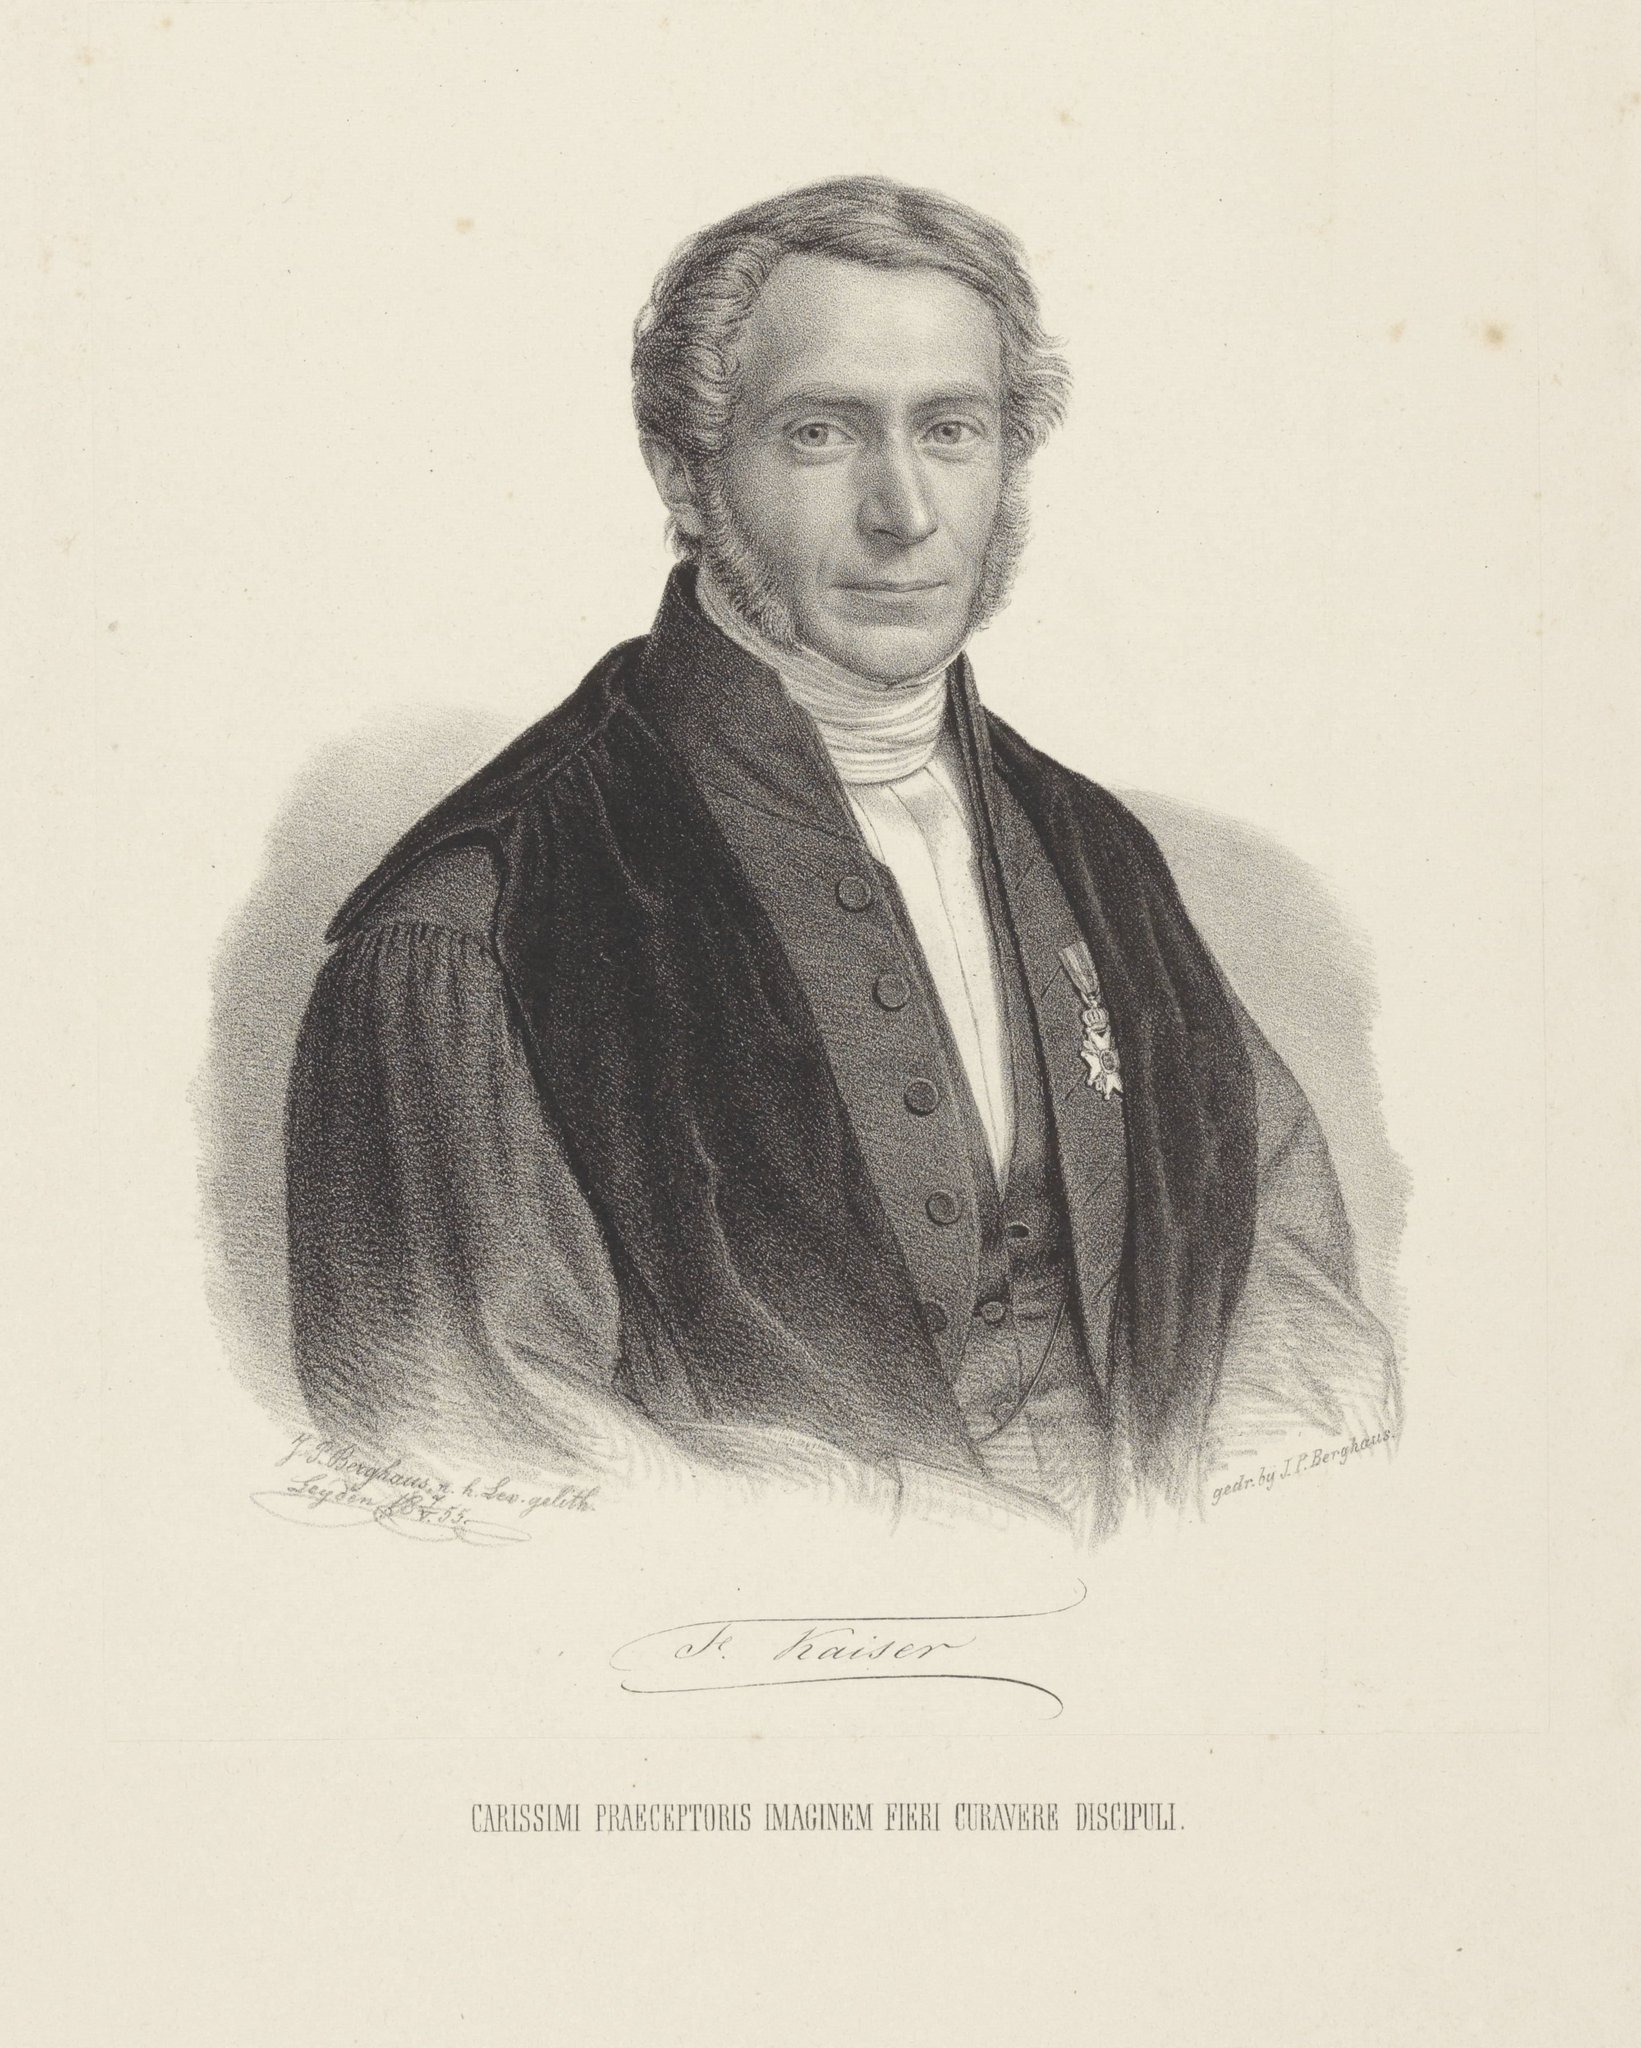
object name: print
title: Portret van Frederik Kaiser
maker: johann peter berghaus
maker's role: print maker, printer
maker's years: 1810-1870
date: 1855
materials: paper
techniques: lithograph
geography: netherlands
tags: amsterdam, leiden, frederik kaiser, knighthood order, historical persons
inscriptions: collector's mark: Lugt 2228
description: De geportretteerde draagt een toga en een ridderorde op de borst. Onder het portret zijn signatuur en een onderschrift in Latijn.